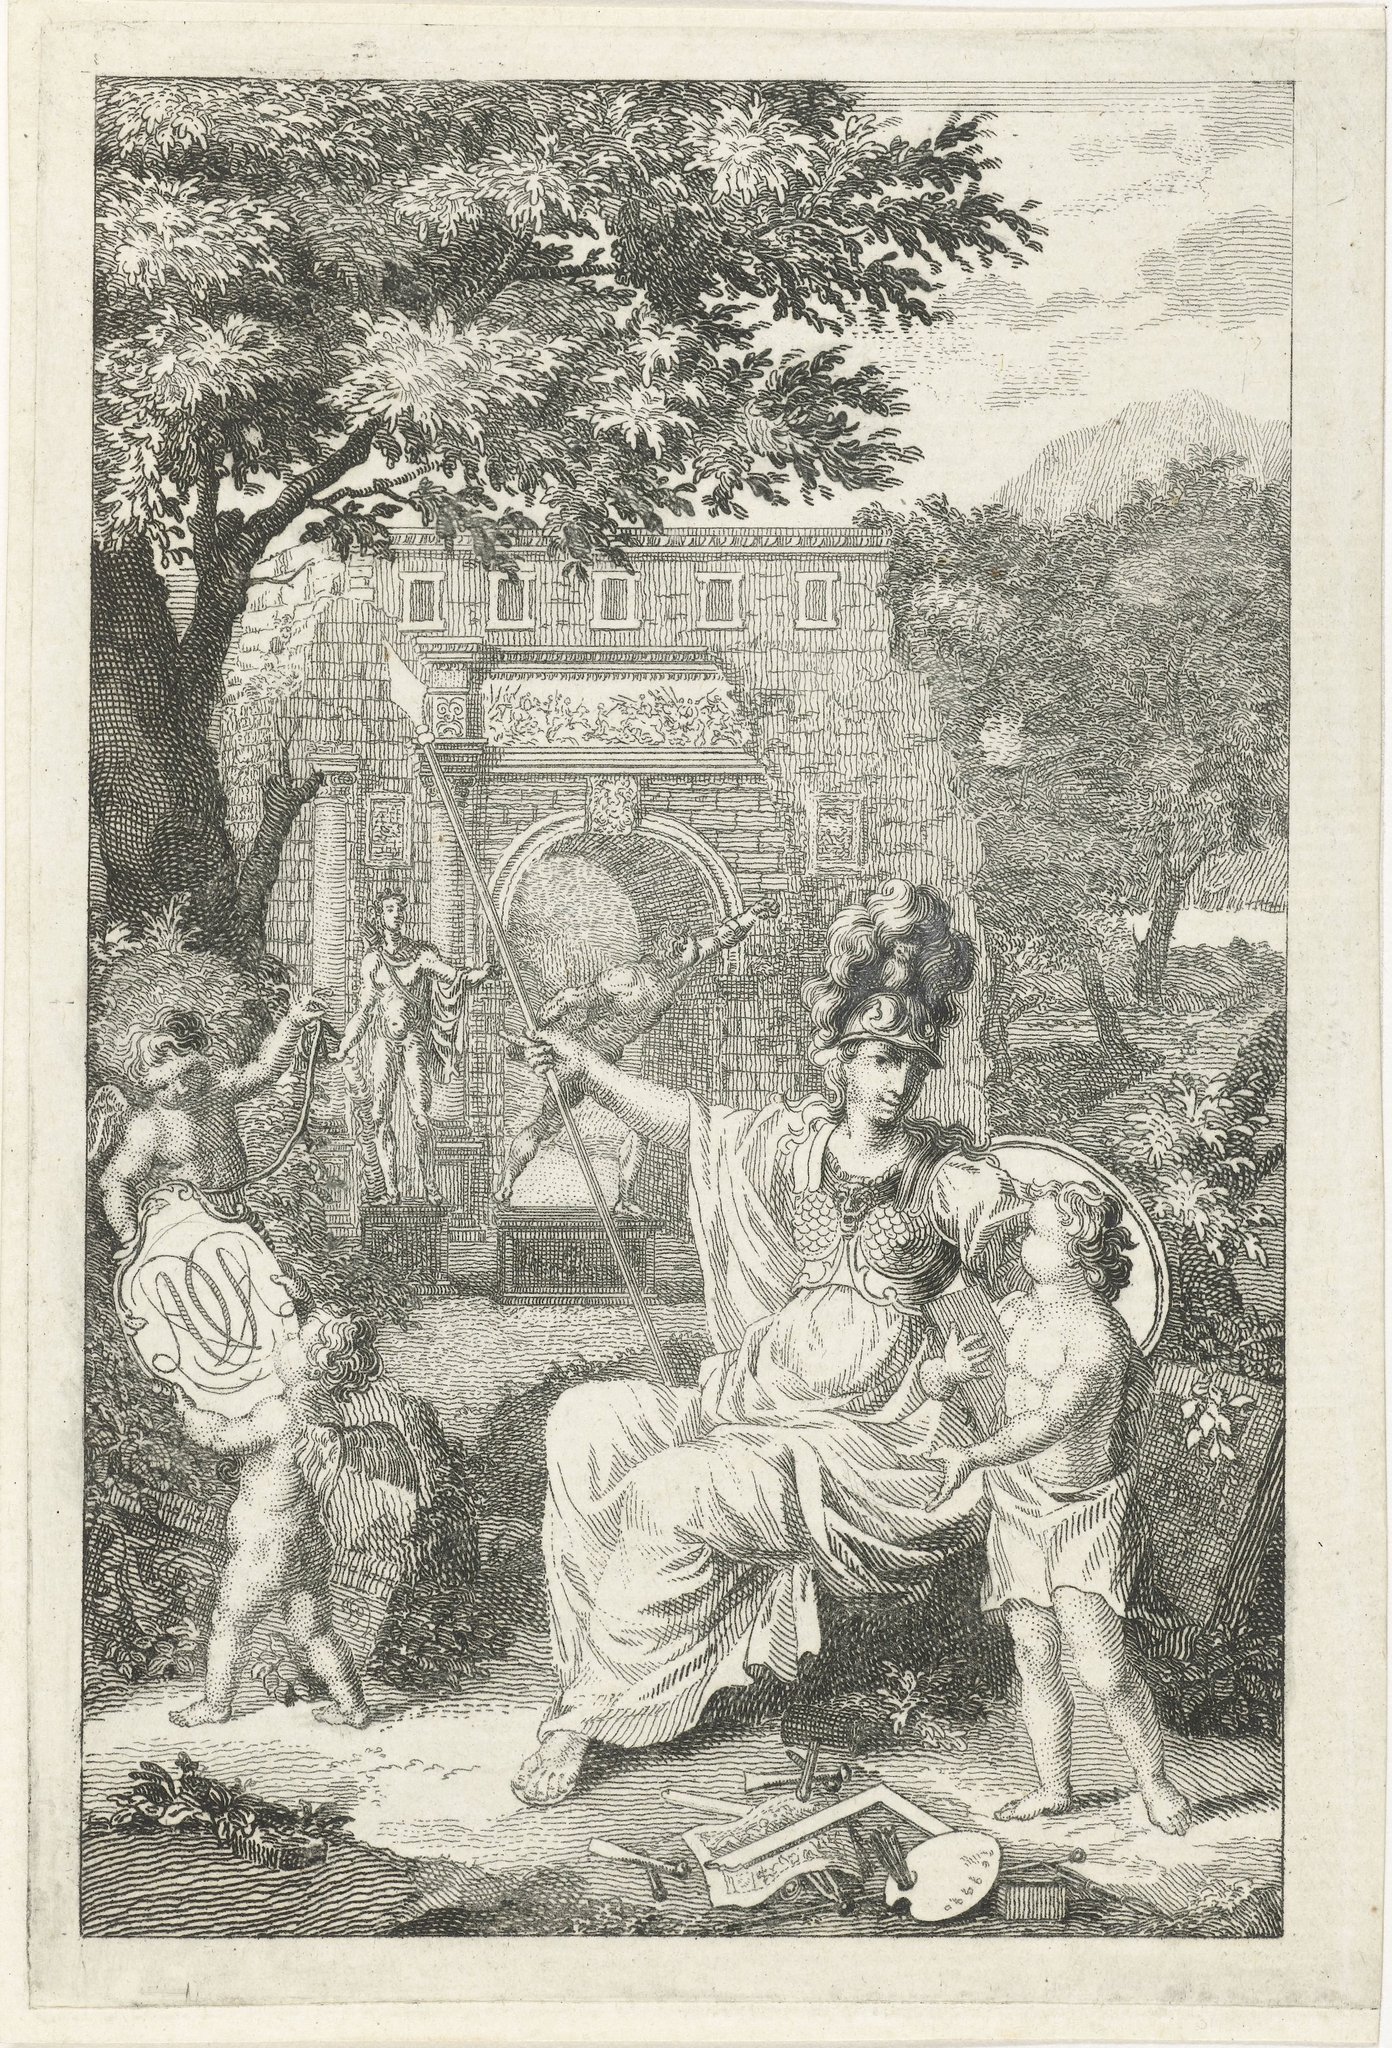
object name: print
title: Allegorie met Minerva als patrones van de kunsten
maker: abraham delfos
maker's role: draughtsman, painter, print maker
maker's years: 1731-1820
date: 1754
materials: paper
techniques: etching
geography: leiden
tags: (story of) minerva (pallas, athena), symbolic representations, allegories and emblems ~ art; 'arte' (ripa)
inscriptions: collector's mark: Lugt 240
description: Allegorie met Minerva als patrones van de kunsten zittend in landschap voor ruïne van triomfboog en griekse beelden. Op de grond liggen kunstenaars gereedschappen. Twee kleine engelen dragen schild met monogram.